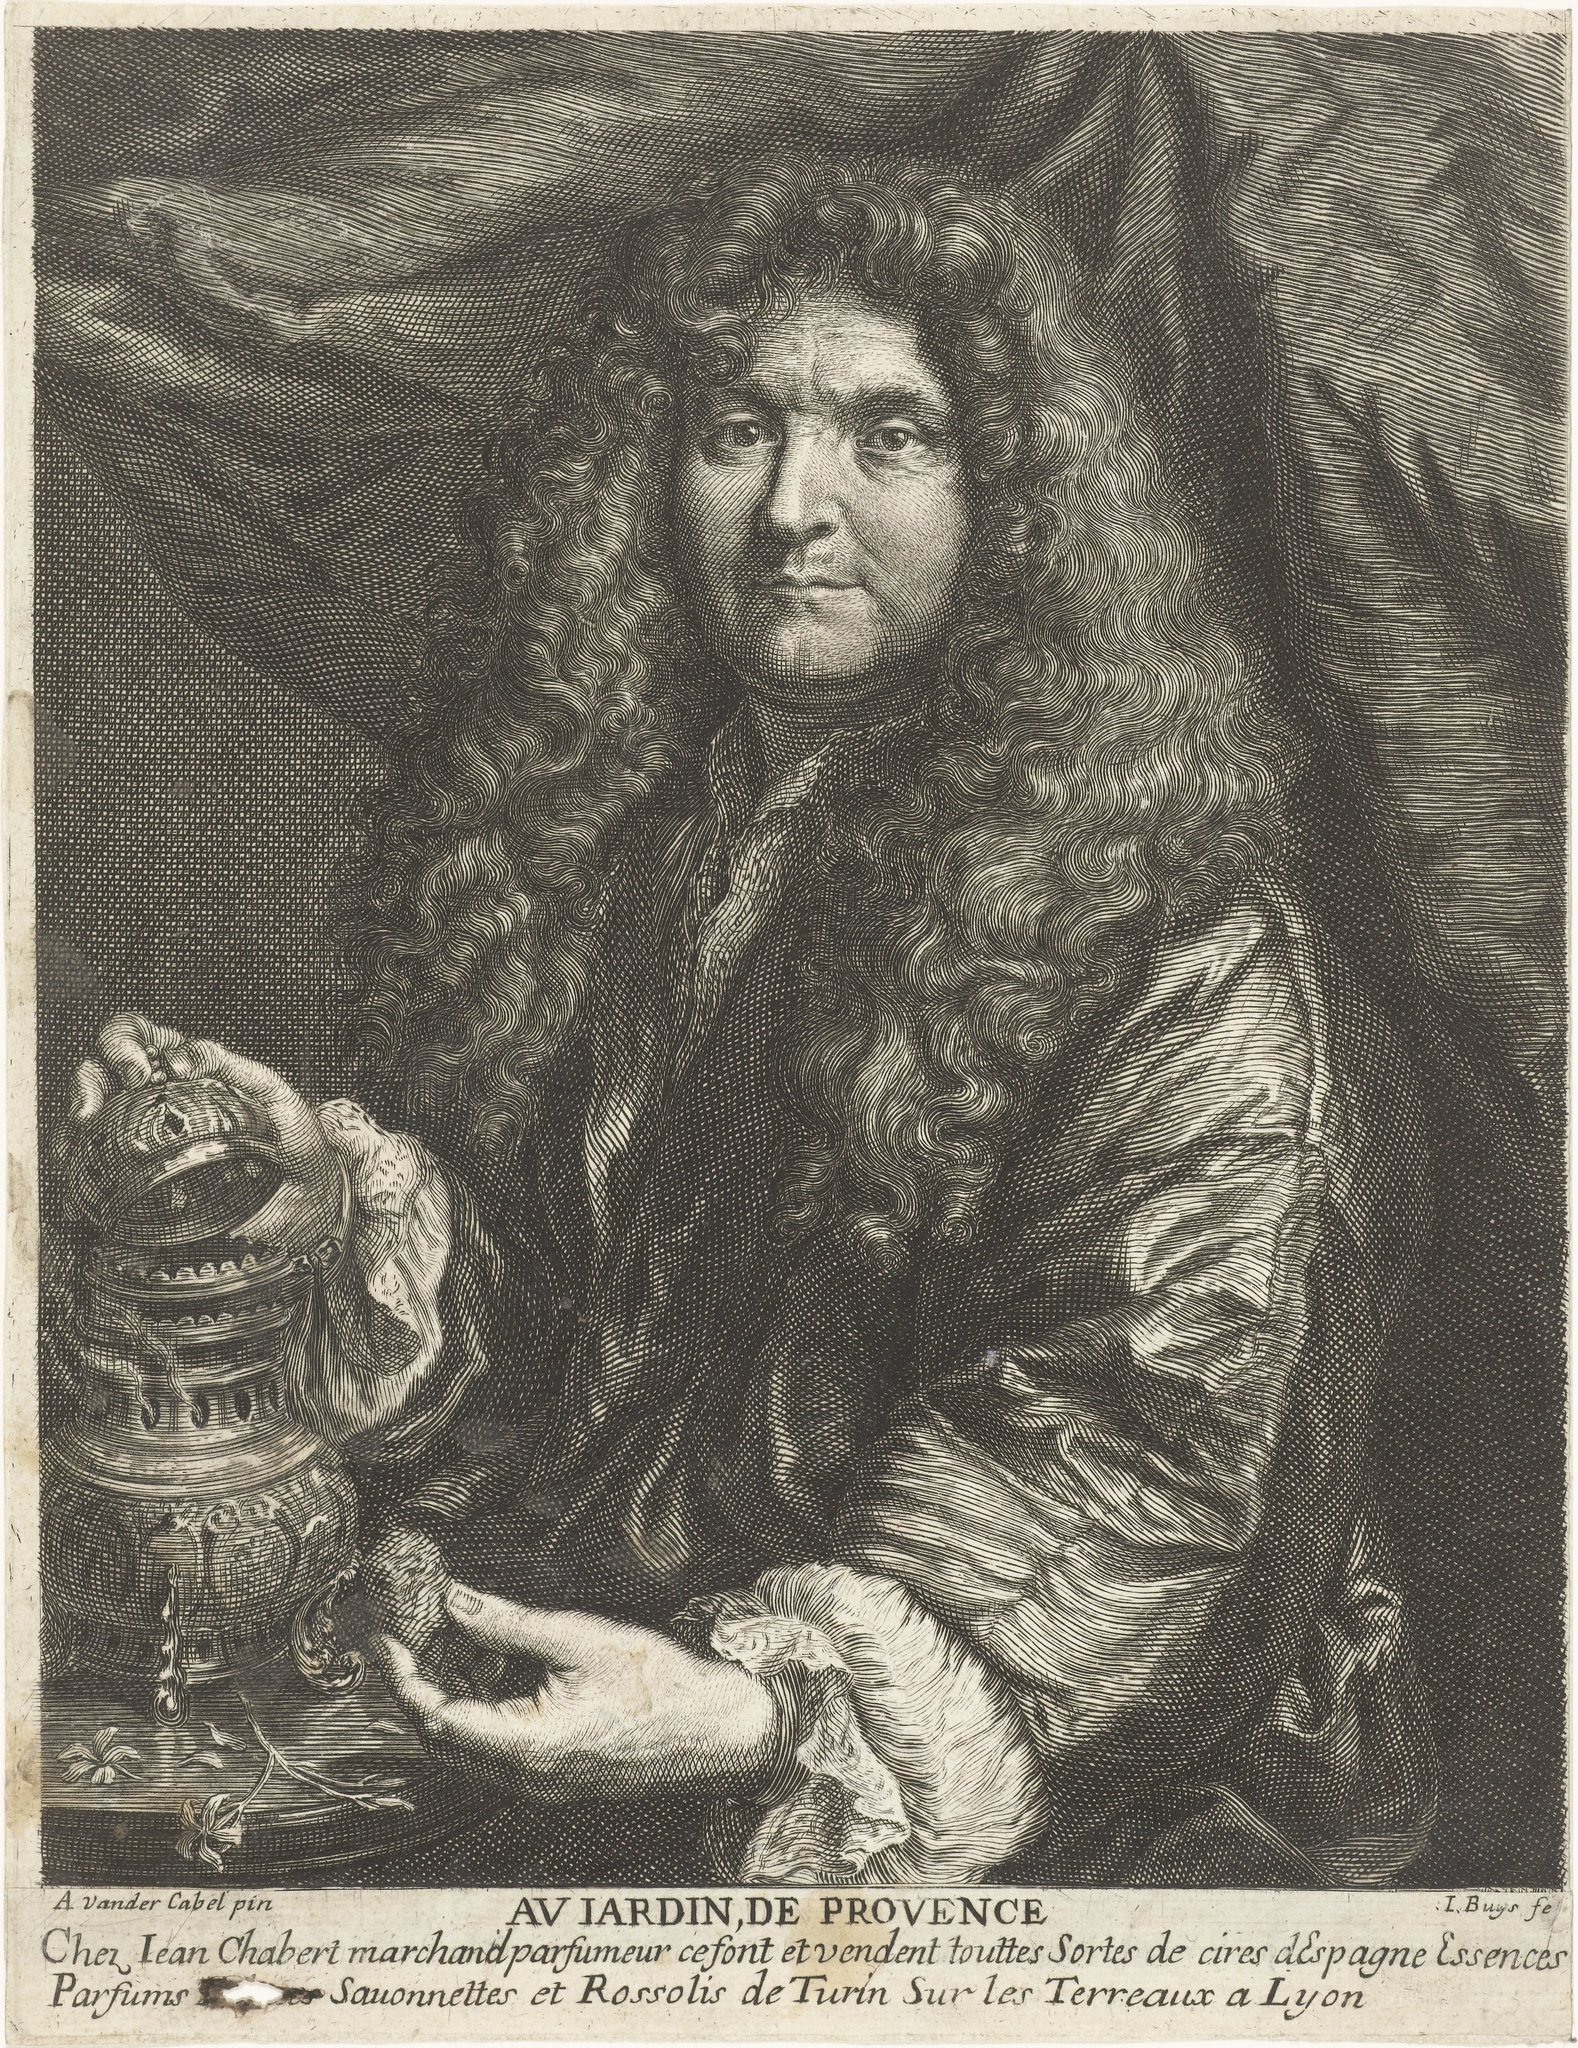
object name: print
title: Portret van de parfumeur Jean Chabert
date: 1675-1700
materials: paper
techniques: engraving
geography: lyon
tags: scents, perfumes ~ stimulants, drugs (+ foodstuffs in other container, e.g.: barrel, can, cask, tin, etc.), perfumes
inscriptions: collector's mark: ‘L. [?] 20.X.1787.’, collector's mark: Lugt 2228